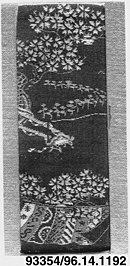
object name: piece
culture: japanese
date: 1701-1900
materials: silk